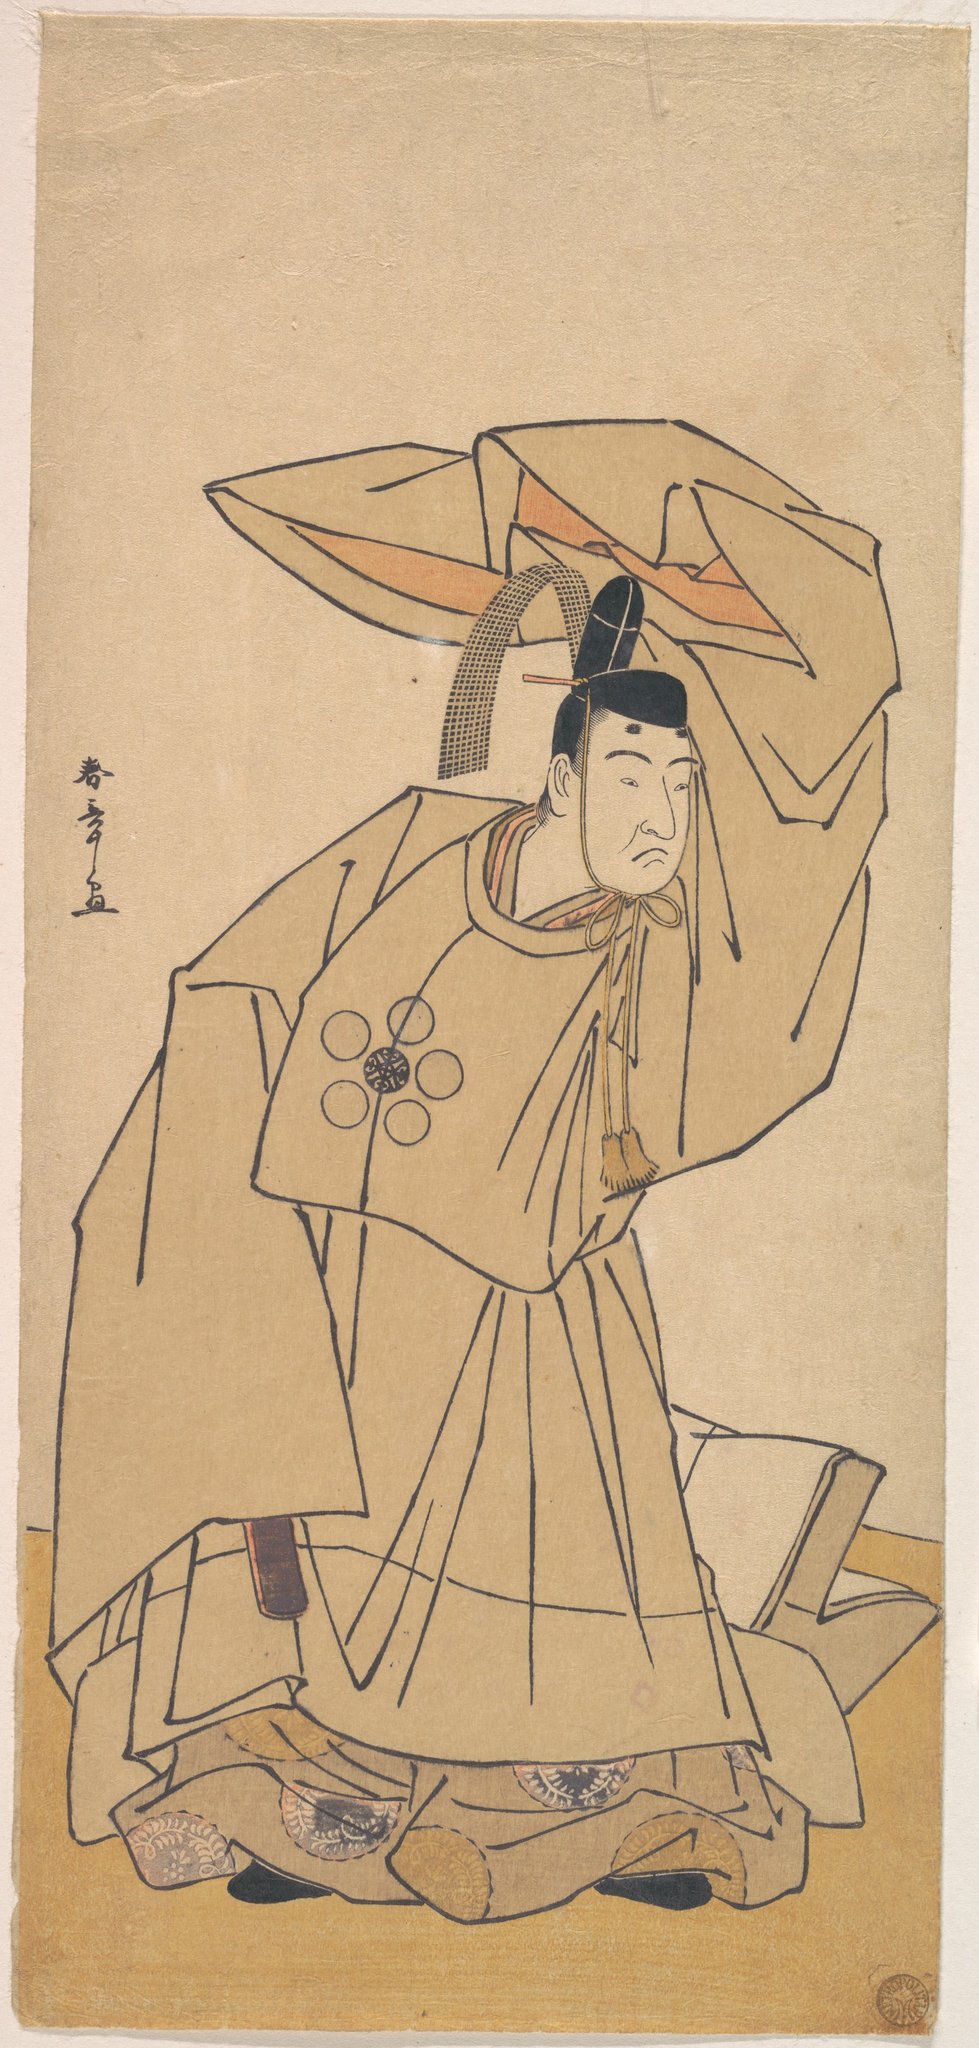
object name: woodblock print nishiki e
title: The First Nakamura Nakazo in the Role of Kanshojo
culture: japanese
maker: katsukawa shunshō 勝川春章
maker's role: artist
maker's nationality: japanese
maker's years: 1726-1792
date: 1780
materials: ink, paper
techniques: nishiki e, woodblock print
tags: men,actors